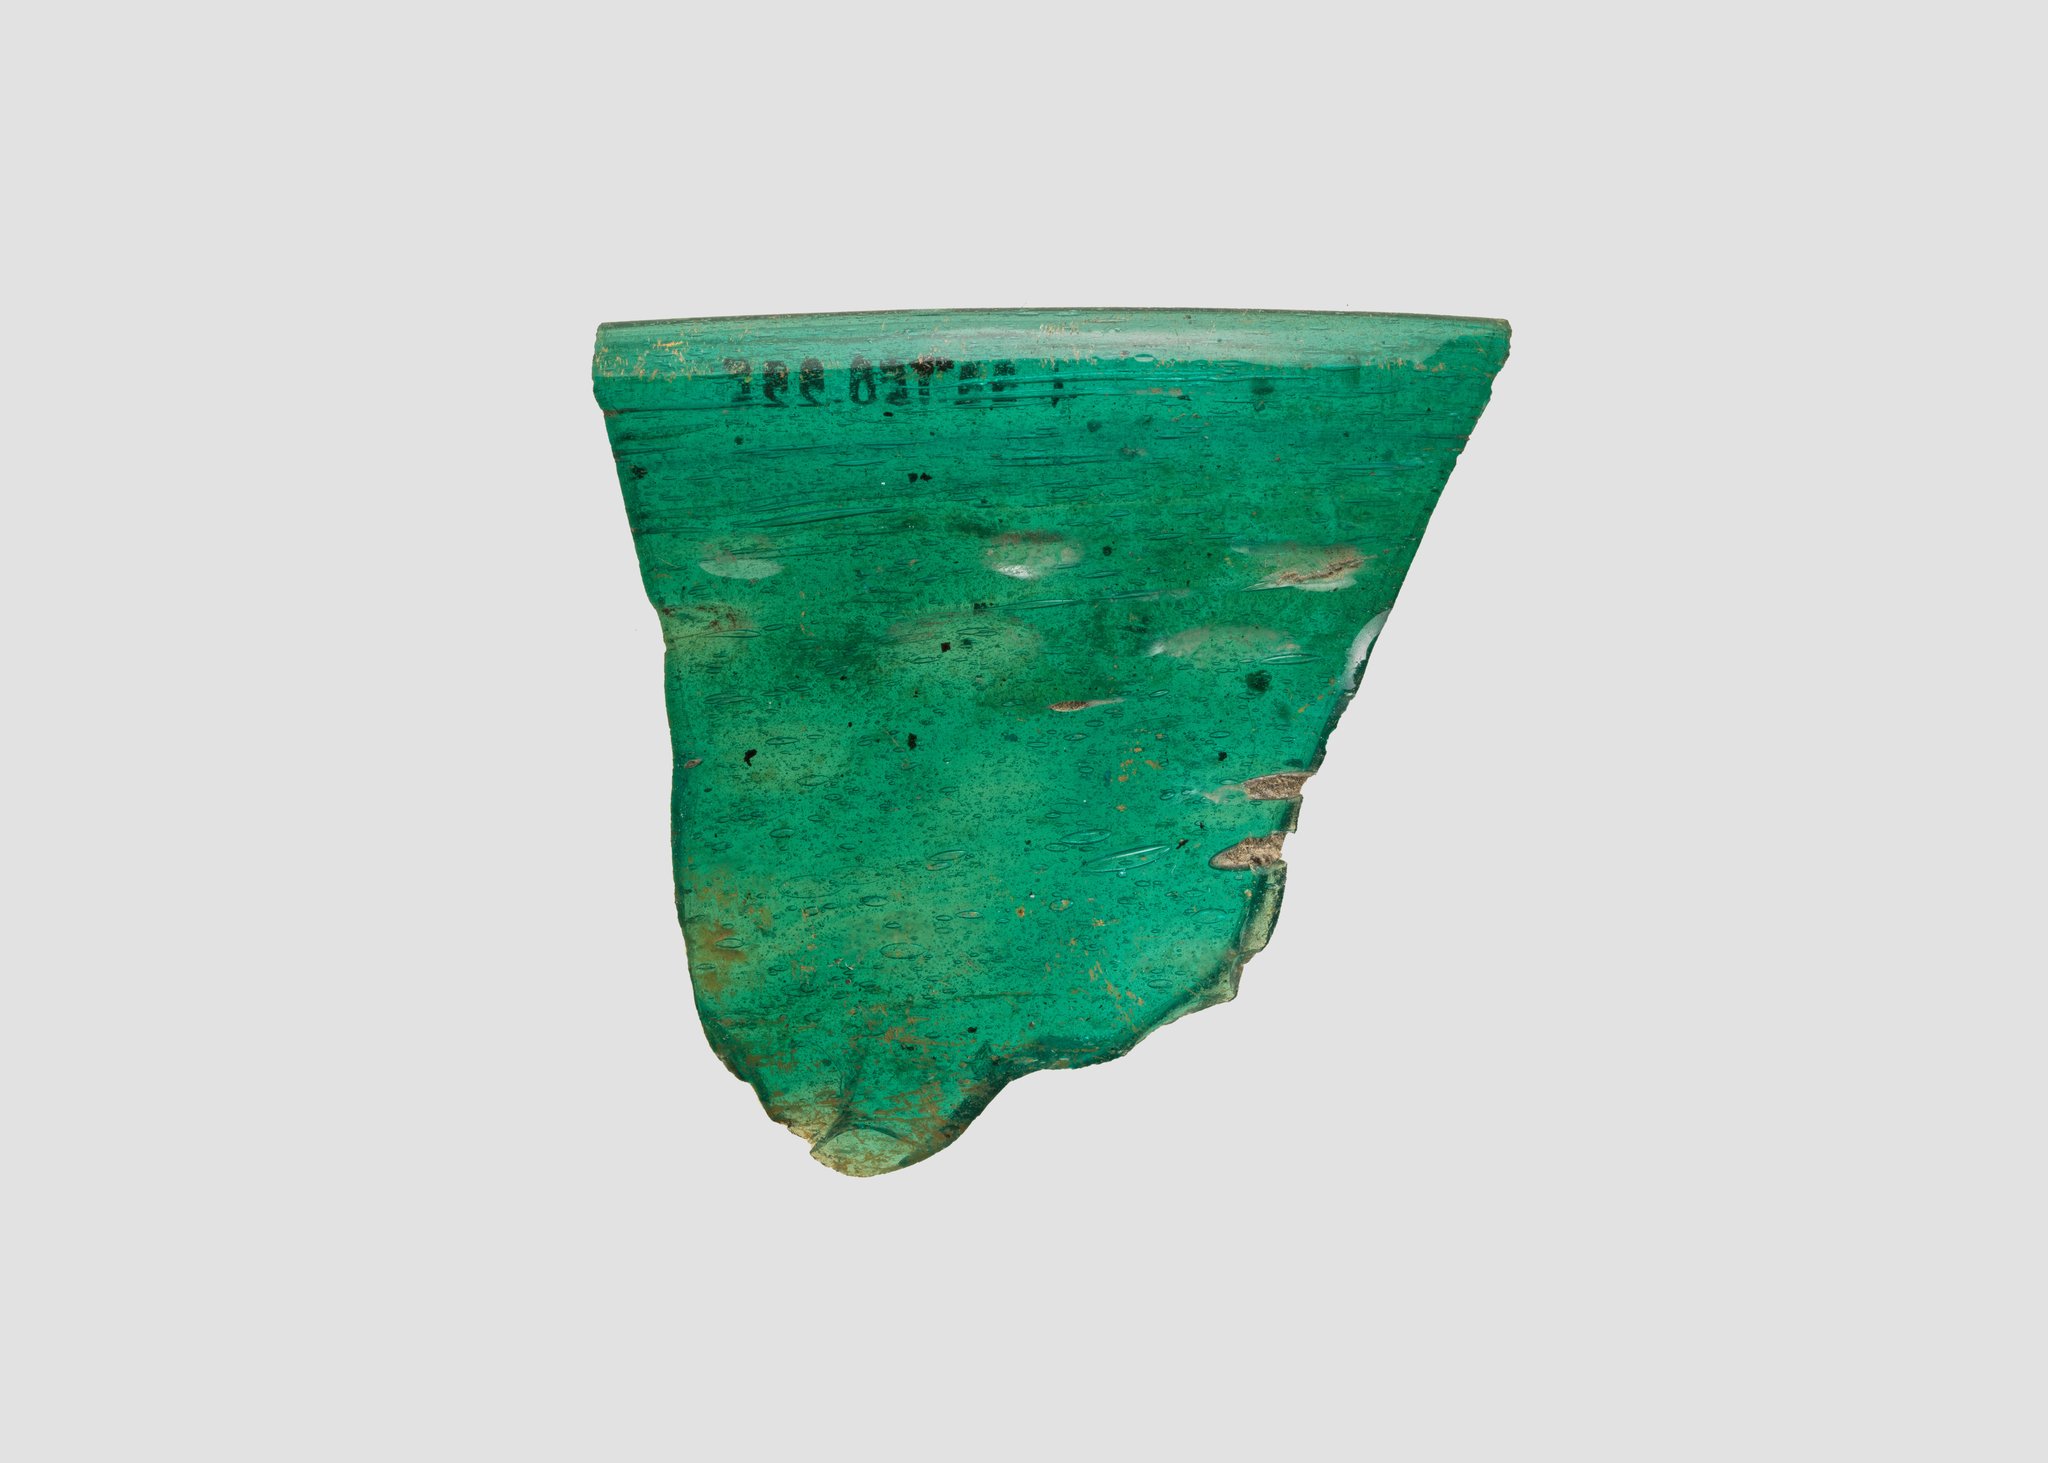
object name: bowl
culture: sasanian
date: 201-700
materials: glass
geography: mesopotamia